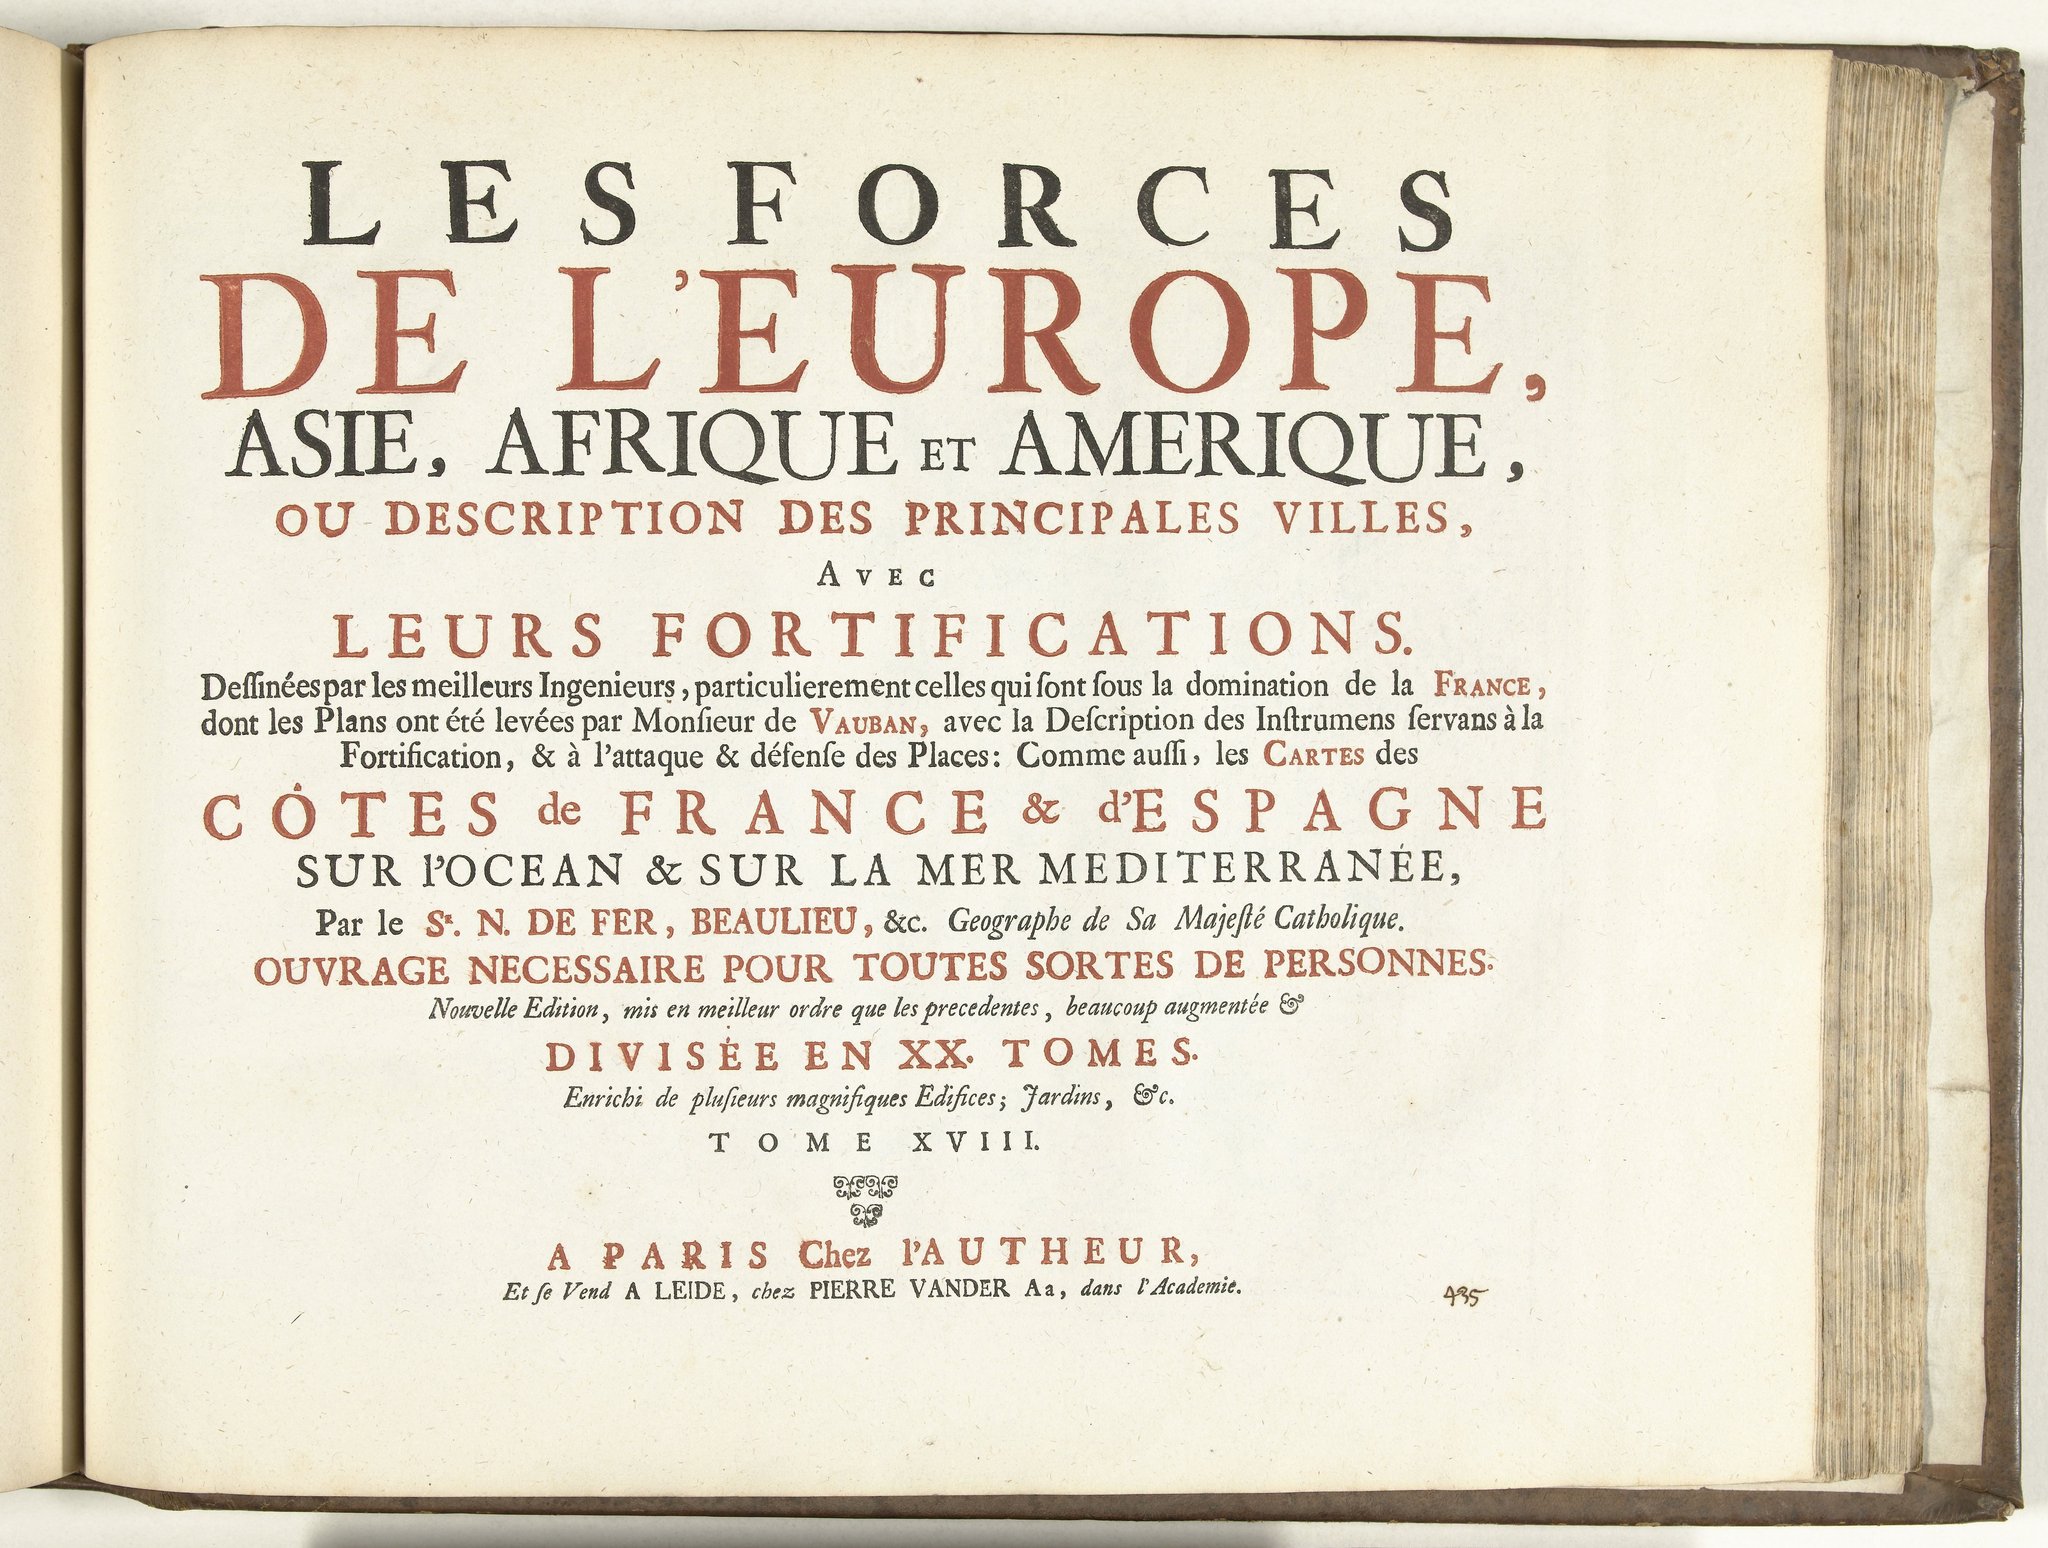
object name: titelblad, titelpagina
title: Titelpagina voor het prentwerk: Les Forces de l'Europe, Asie, Afrique et Amerique (...) Comme aussi les Cartes des Côtes de France et d'Espagne (deel XVIII), 1726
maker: pieter van der aa (i)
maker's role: printer, publisher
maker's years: 1659-1733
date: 1726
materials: paper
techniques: letterpress printing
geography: leiden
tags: spaanse successieoorlog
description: Titelpagina gedrukt in zwart en rood voor deel XVIII van het prentwerk Les Forces de l'Europe, Asie, Afrique et Amerique ... Comme aussi les Cartes des Côtes de France et d'Espagne, 1726. Dit tweede deel van het prentwerk bestaat uit 271 met de hand genummerde platen van vermaarde sterke steden en vestingen in het kader van de Spaanse Successieoorlog 1701-1713. Voor het merendeel zijn deze platen gekopieerd naar de anonieme Franse platen van vermaarde sterke steden en vestingen: in Les forces de l'Europe en in: Le theatre de la guerre, dans les Pays-Bas, beide oorspronkelijk uitgegeven door Nicolas de Fer te Parijs (1693-1697) in het kader van de Negenjarige Oorlog. Titel in het Frans.